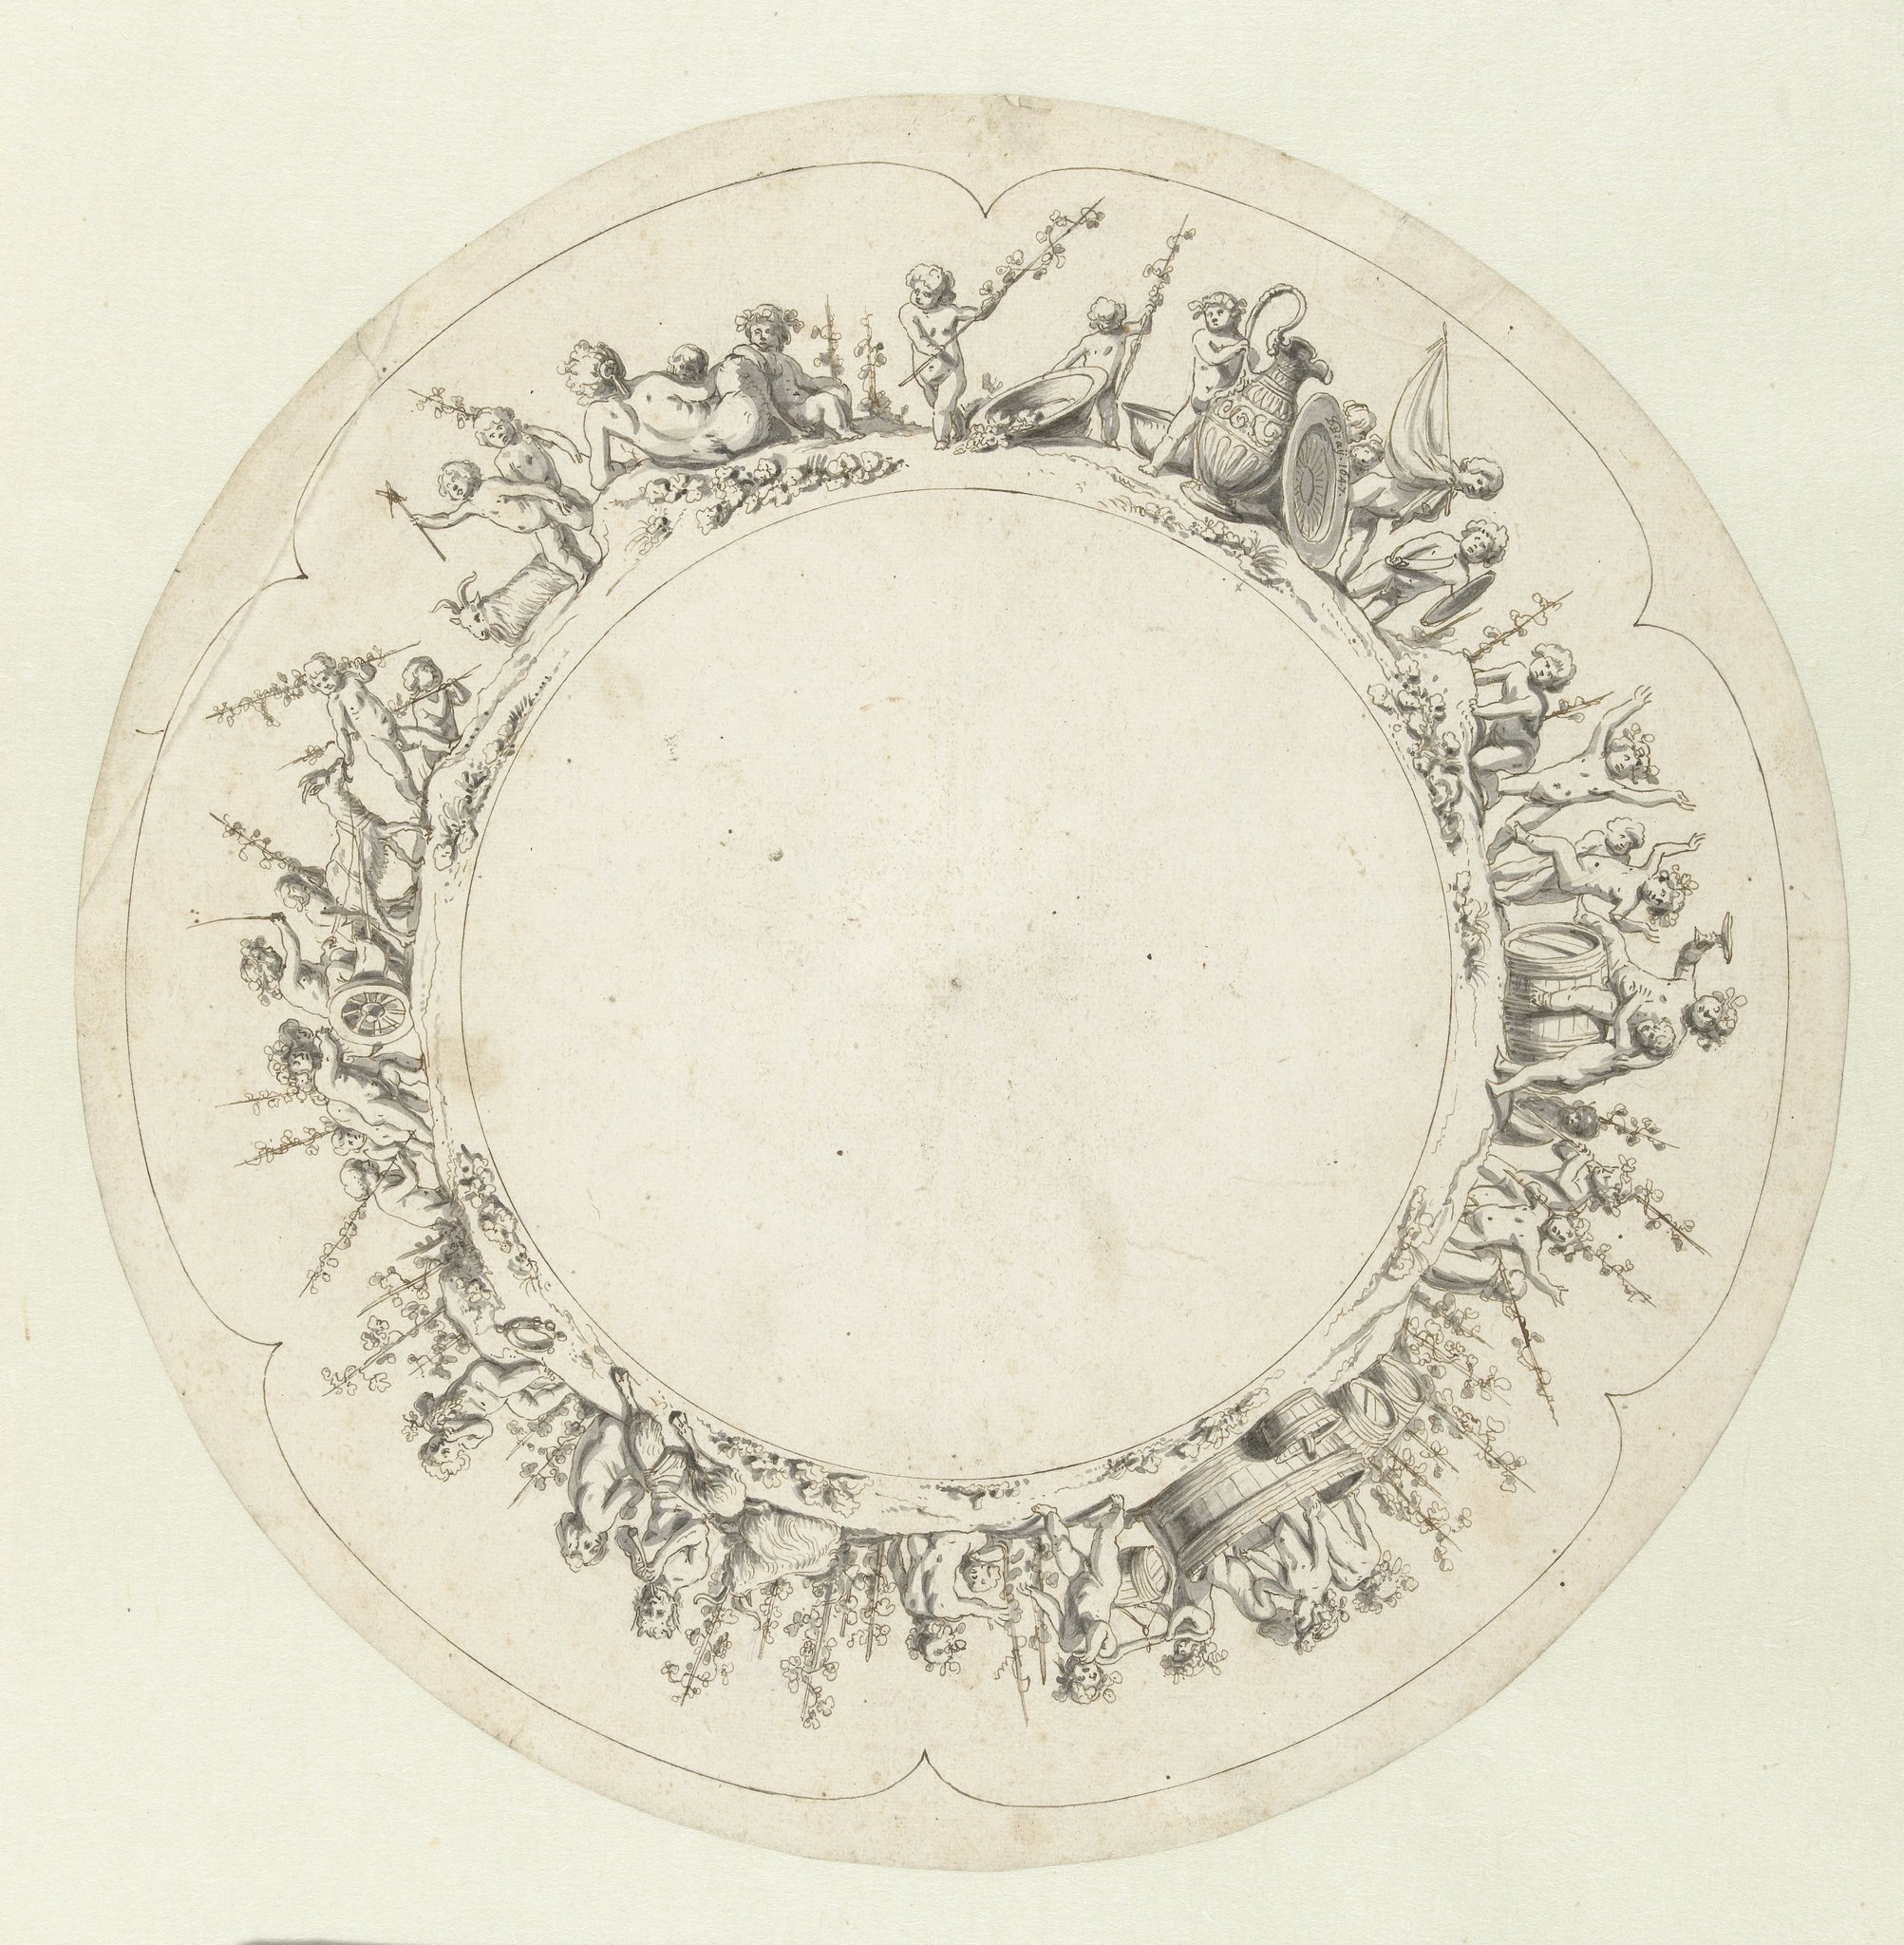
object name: drawing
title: Design for a Silver Dish, the Rim Decorated with Cupids, a Nude Woman and Two Satyrs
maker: salomon de bray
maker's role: draughtsman, print maker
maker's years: 1597-1664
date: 1647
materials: ink, paper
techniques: brush, pen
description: Ontwerp voor een zilveren schaal, waarvan de rand gedecoreerd is met een doorlopende voorstelling van putti die zich bezighouden met de wijnbouw.